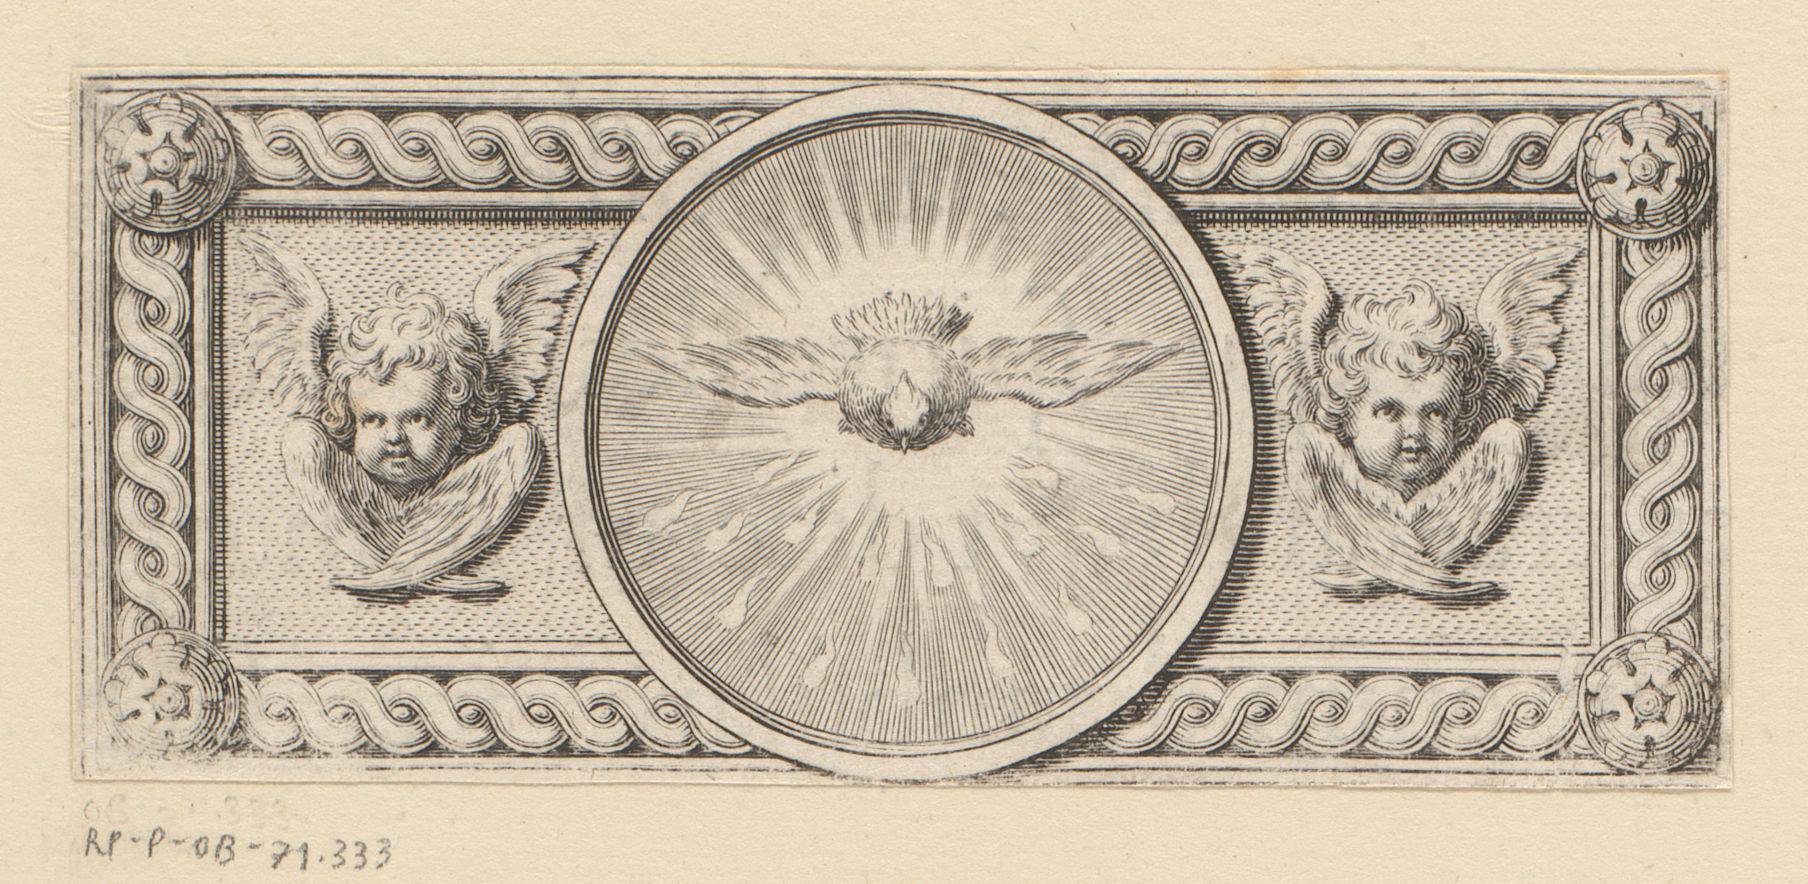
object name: book illustration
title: Fries met Heilige Geest als duif met twee cherubijnen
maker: claude mellan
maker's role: draughtsman, print maker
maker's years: 1598-1688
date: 1608-1688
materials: paper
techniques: engraving, letterpress printing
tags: cherubs, i.e. children's heads with wings, holy ghost represented as a dove (in flames)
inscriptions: collector's mark: Lugt 240